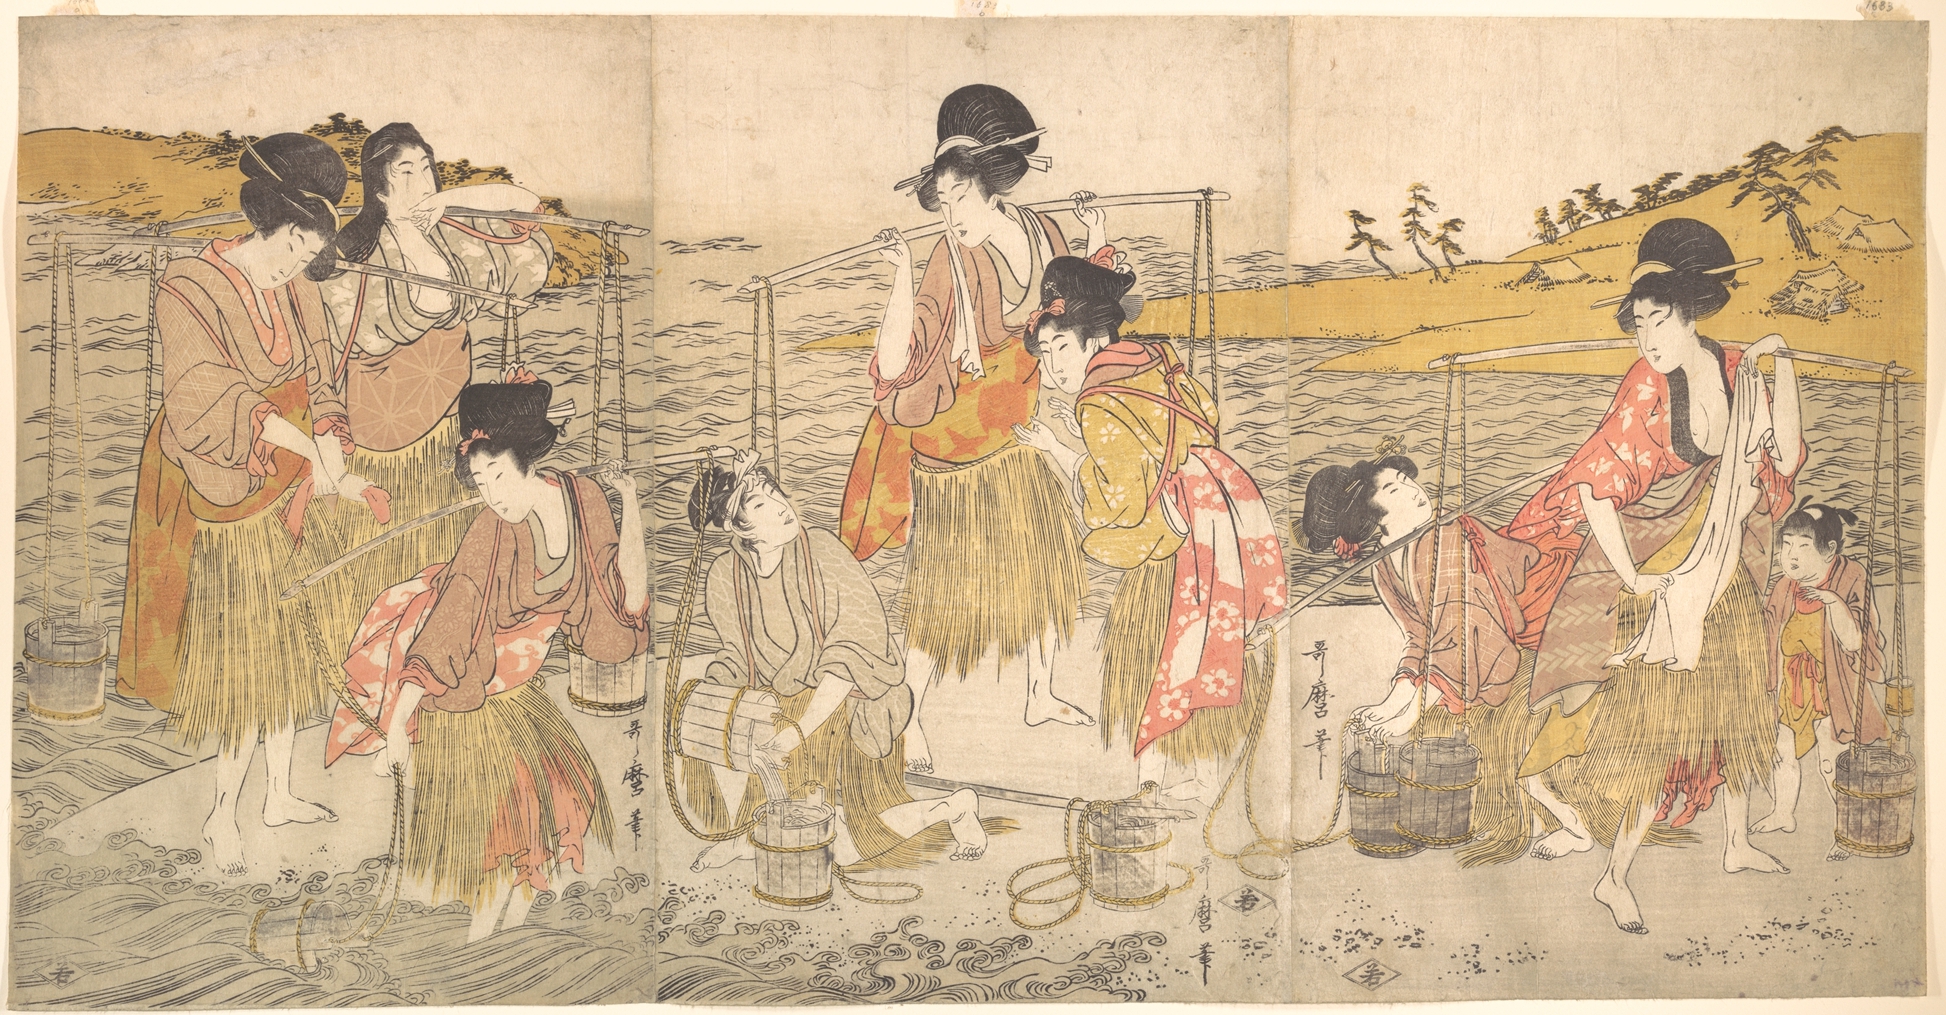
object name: print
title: The Dance of the Beach Maidens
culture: japanese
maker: kitagawa utamaro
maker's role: artist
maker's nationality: japanese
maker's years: 1754-1806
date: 1801-1833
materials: ink, paper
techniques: woodblock print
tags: dance,women,beaches